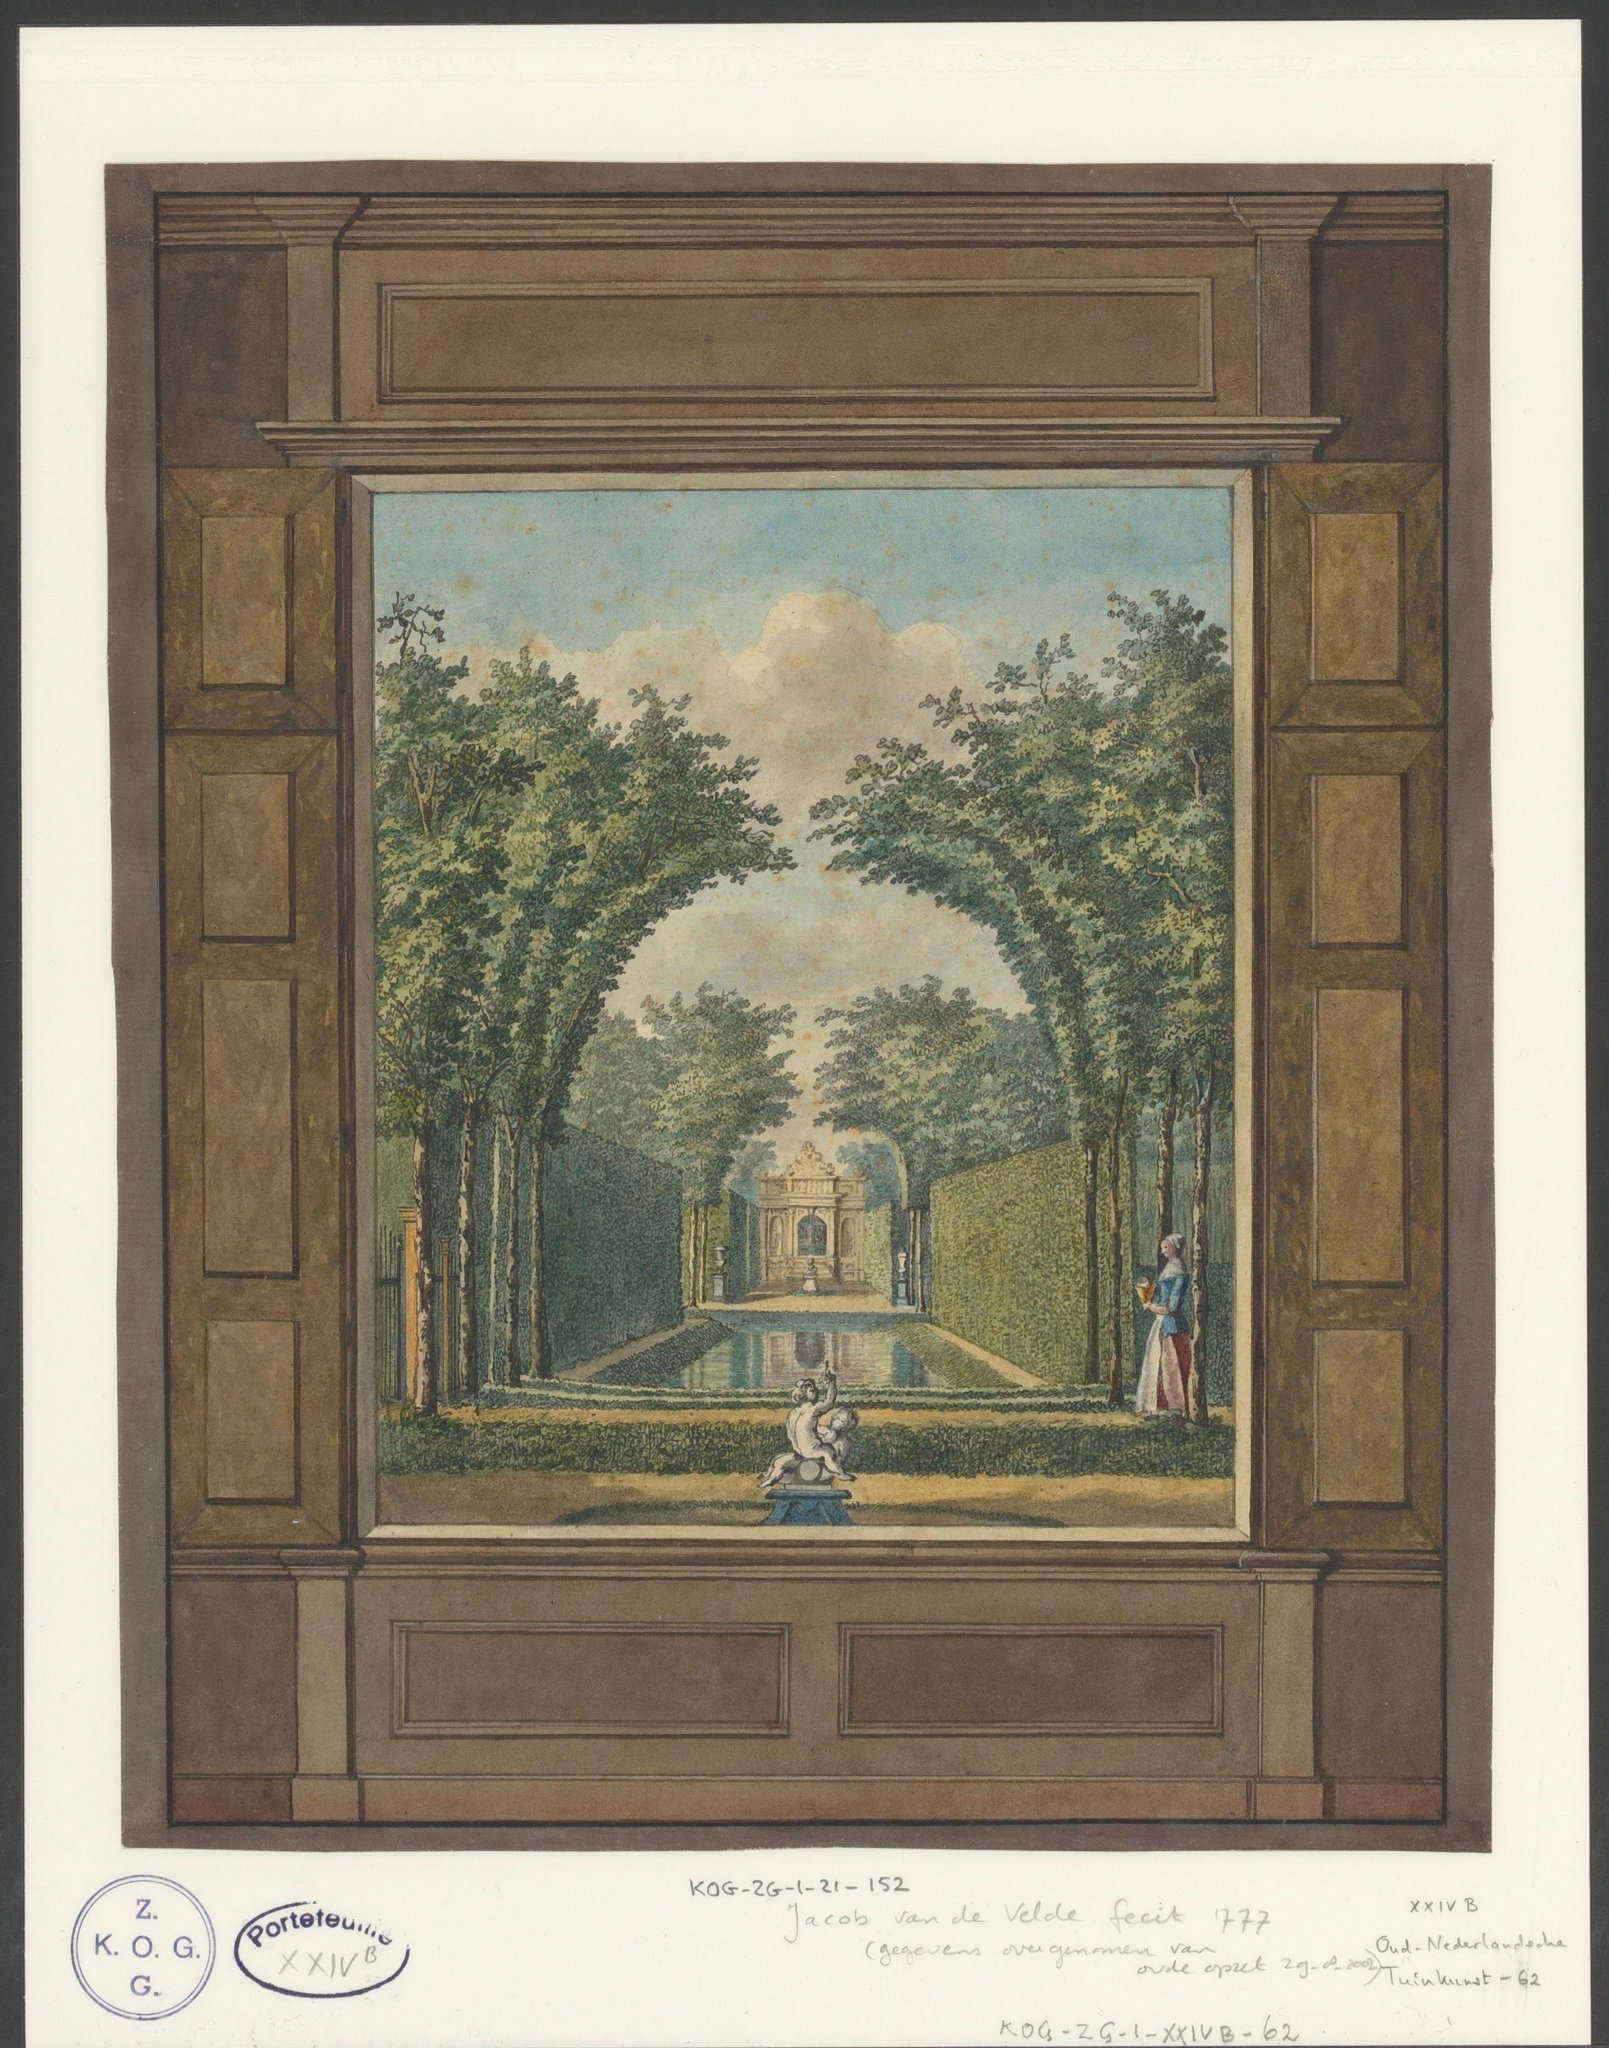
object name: drawing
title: Vijver van een tuin, gezien door een venster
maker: jacob van de velde (graveur)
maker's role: print maker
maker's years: 1744-1780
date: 1777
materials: chalk, paper, watercolor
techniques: brush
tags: (story of) bacchus (dionysus), liber, french or architectonic garden; formal garden, garden pond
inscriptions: collector's mark: Lugt 1641, stamp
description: Gezicht op een tuin door een groot venster in een muur, alsof men vanuit een tuinhuis naar buiten kijkt. Op de voorgrond een beeldengroep met twee spelende kinderen. Daarachter een rechthoekige vijver met aan weerszijden hoge geschoren hagen. Op de achtergrond een poort met een doorkijkje naar een fontein. Op de voorgrond rechts een vrouw. Onderwerpsrubrieken binnen de Atlas Zeden en Gewoonten: Zeden en Gewoonten in Engeren Zin, De Woning, Oude Nederlandsche Tuinkunst. De 18de eeuw. De stijl van le Nôtre.